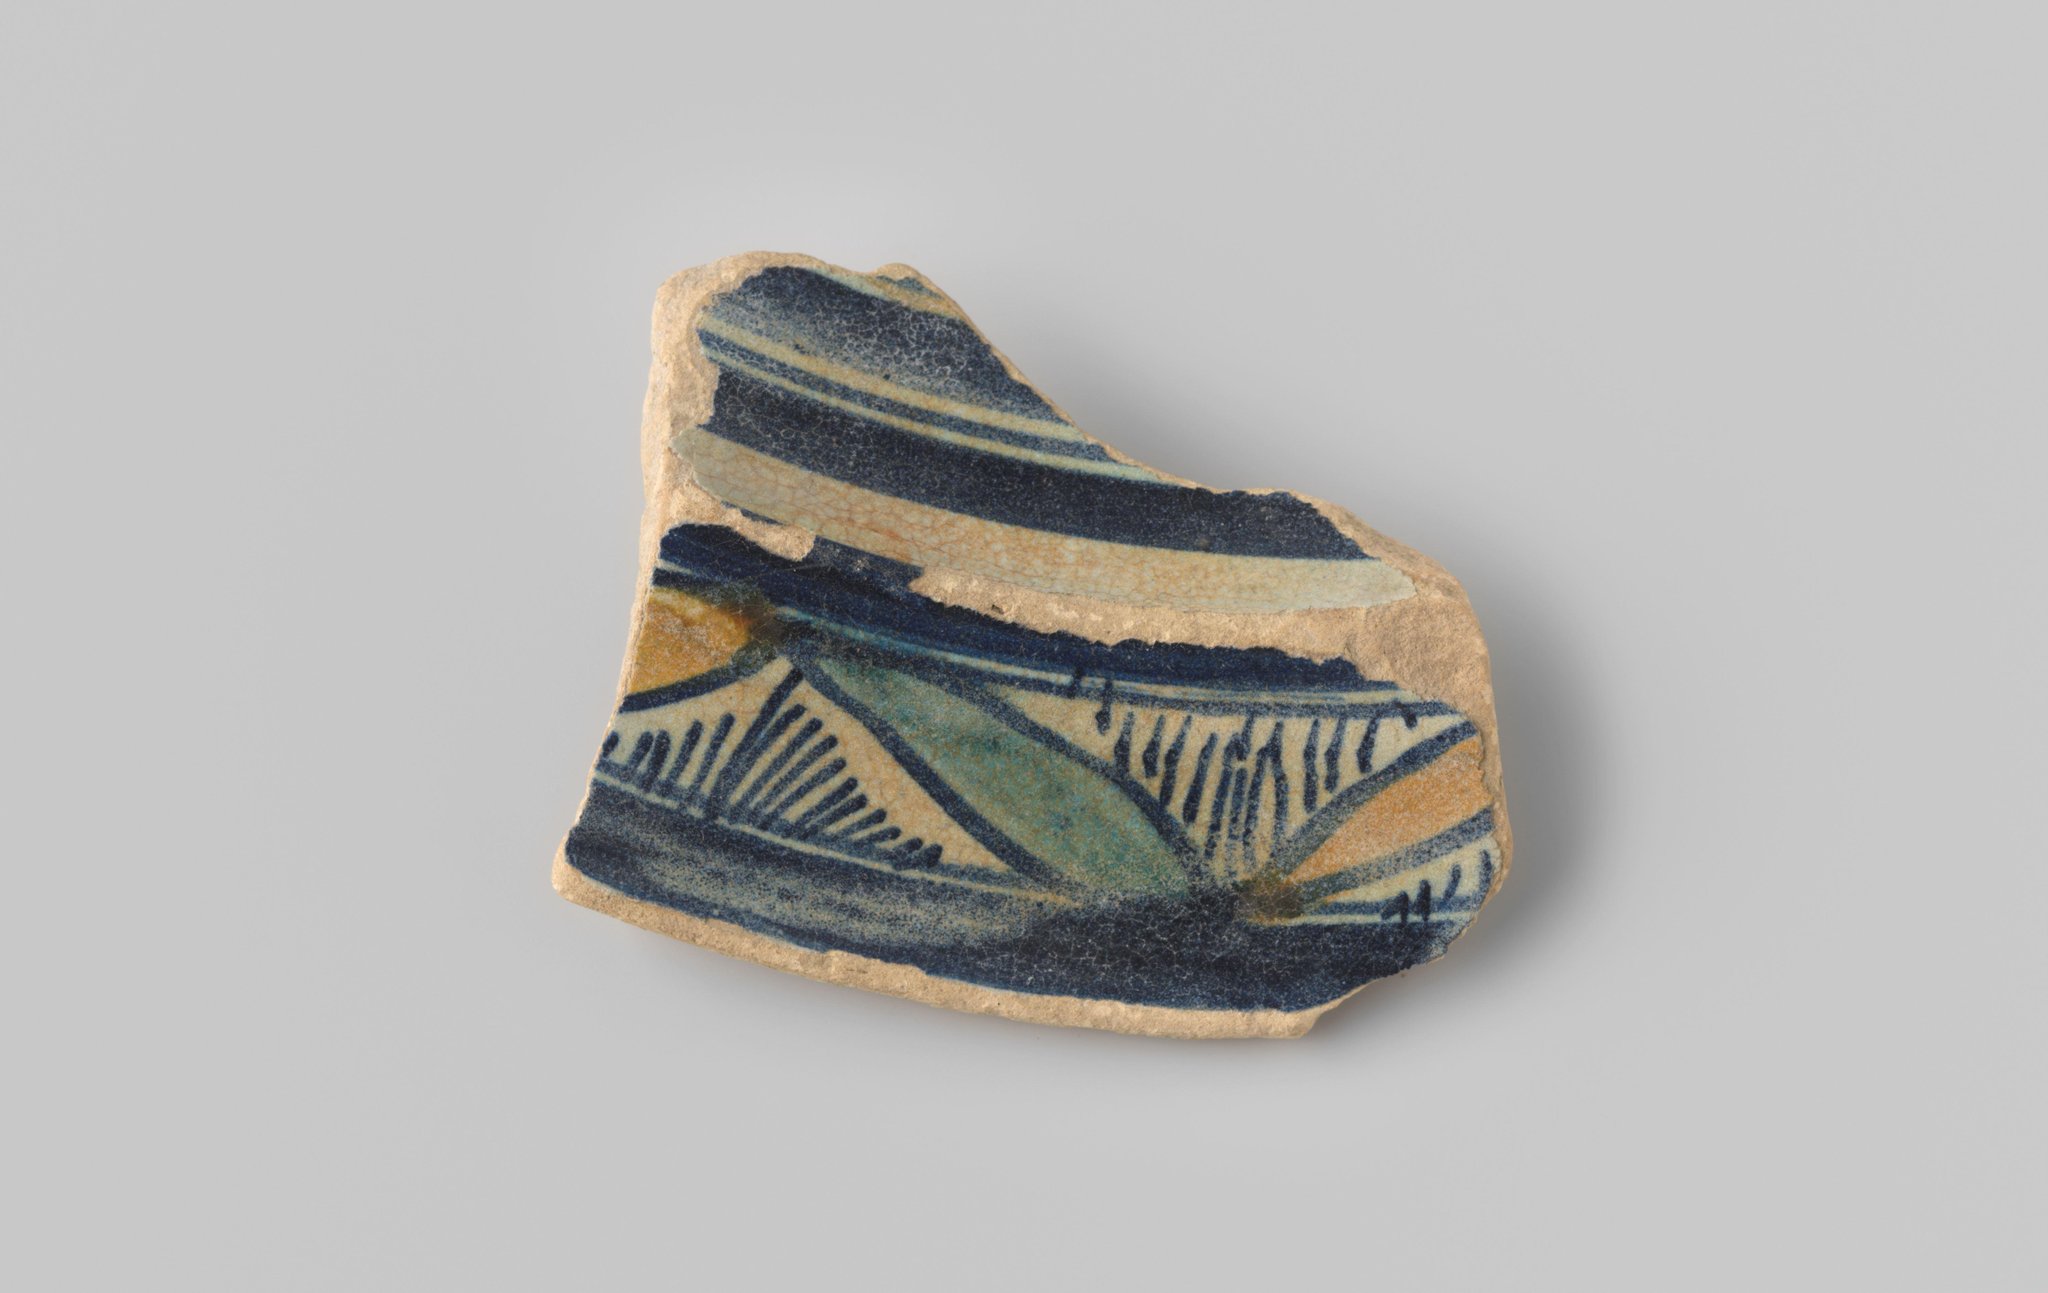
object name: sherd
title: Fragment (voet) met gelige scherf, met banen, strepen en vlakken in blauw en geel op een witte ondergrond aan de bovenzijde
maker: Anonymous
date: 1200-1899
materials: earthenware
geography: italy